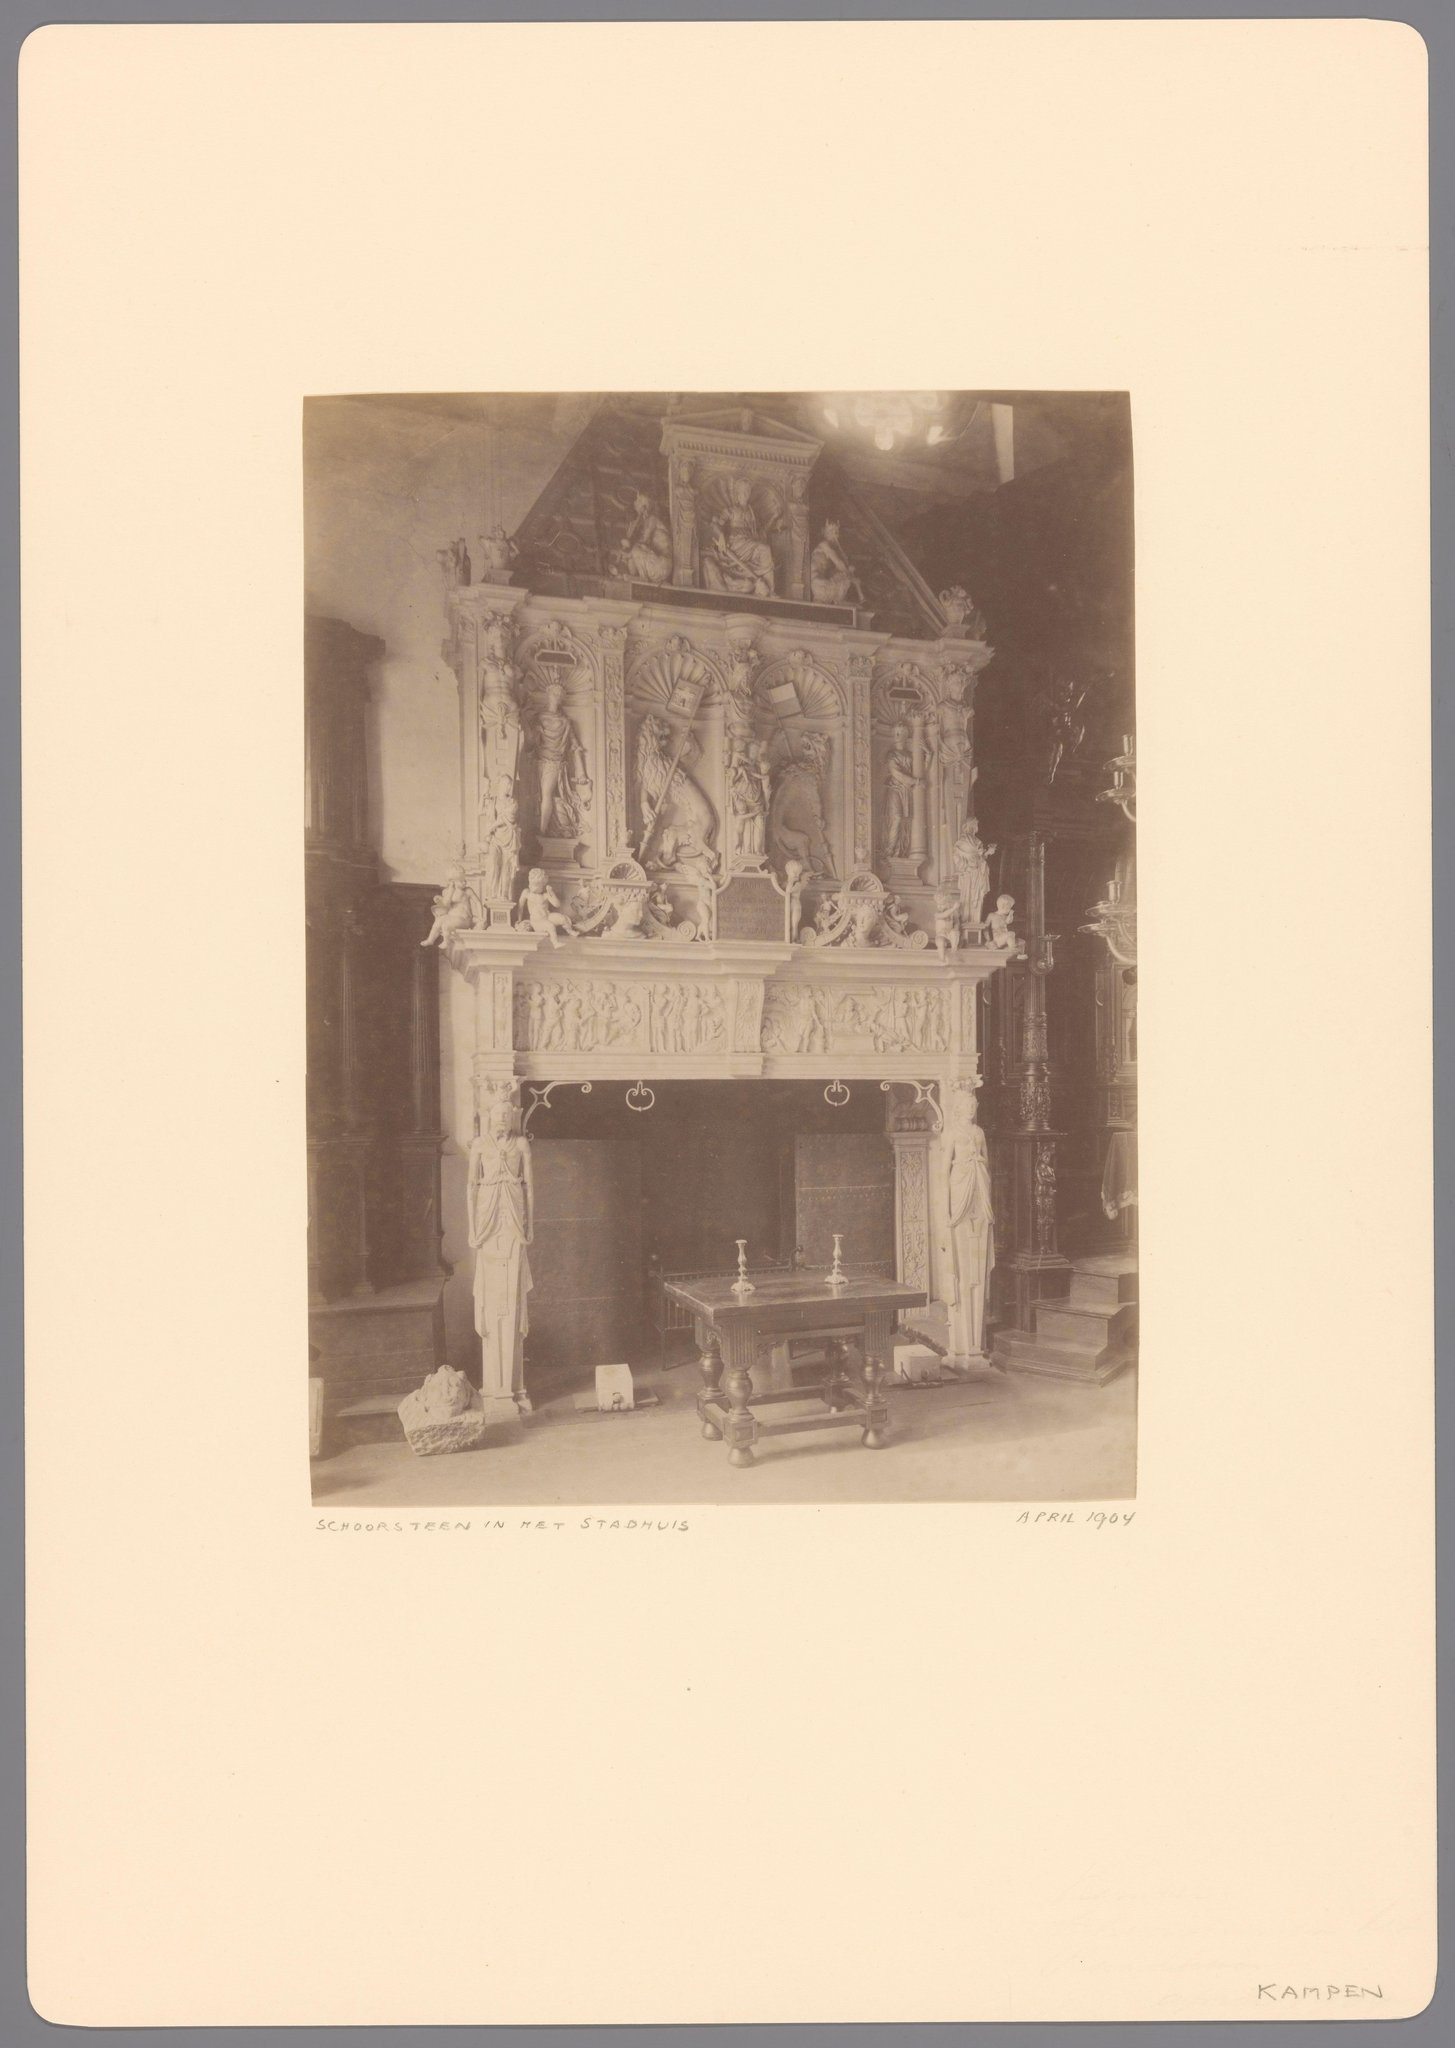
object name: photograph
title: Schoorsteen in het stadhuis van Kampen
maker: anoniem (monumentenzorg)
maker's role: fotograaf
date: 1904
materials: cardboard, photographic support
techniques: albumen print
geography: kampen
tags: townhall, chimney-piece, mantelpiece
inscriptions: annotation: ‘Schoorsteen in het stadhuis/ april 1904/ Kampen’, annotation: ‘Kampen/ schoorsteen in het stadhuis april 1904’